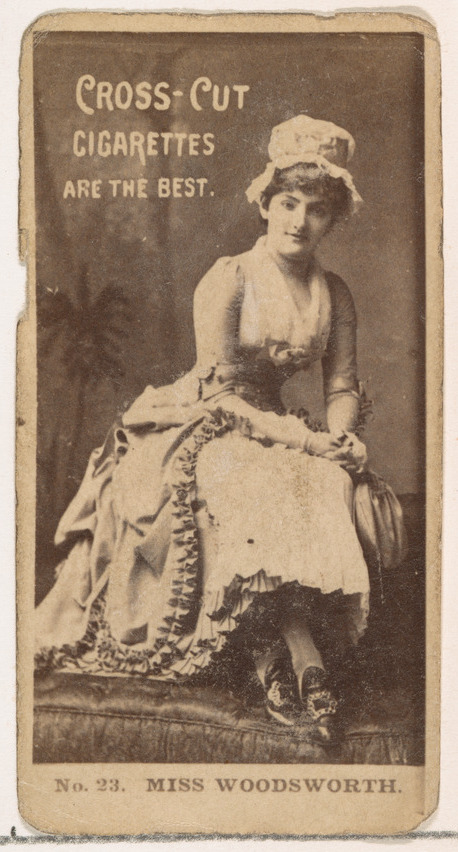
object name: print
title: Card Number 23, Miss Woodsworth, from the Actors and Actresses series (N145-2) issued by Duke Sons & Co. to promote Cross Cut Cigarettes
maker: w. duke, sons & co.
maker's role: publisher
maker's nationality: american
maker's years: 1870-1920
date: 1880-1889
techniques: albumen silver print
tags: portraits,women,actresses